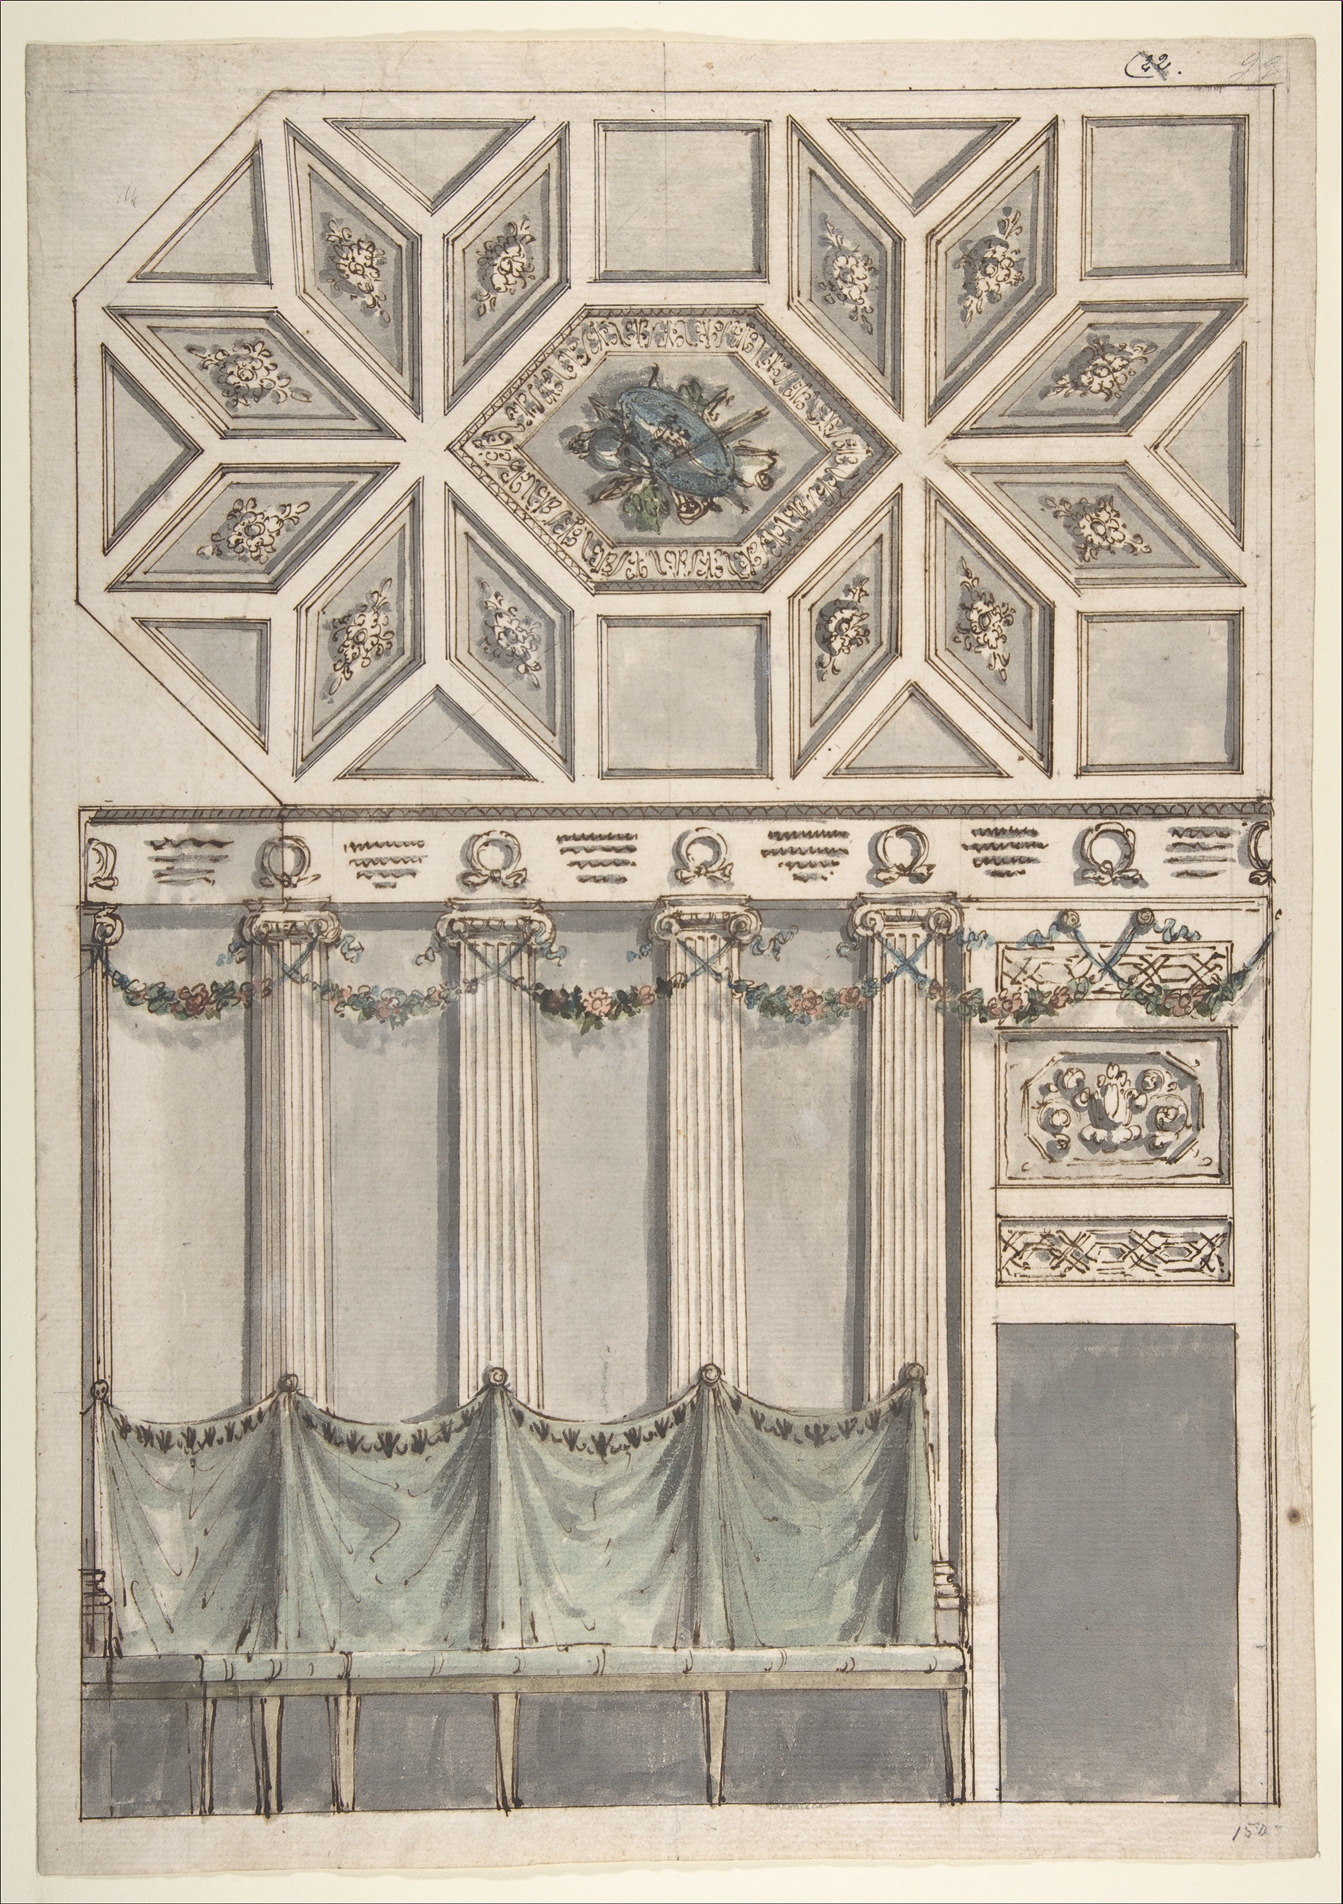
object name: drawing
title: Framed Design for an Architectural Interior: Coffered Ceiling with Central Hexagonal Cartouche and Walls with Floral Ornament and Drapery.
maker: antonio basoli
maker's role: artist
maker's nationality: italian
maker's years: 1774-1843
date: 1774-1839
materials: graphite, ink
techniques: brush, pen, wash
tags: architecture,interiors,ceilings